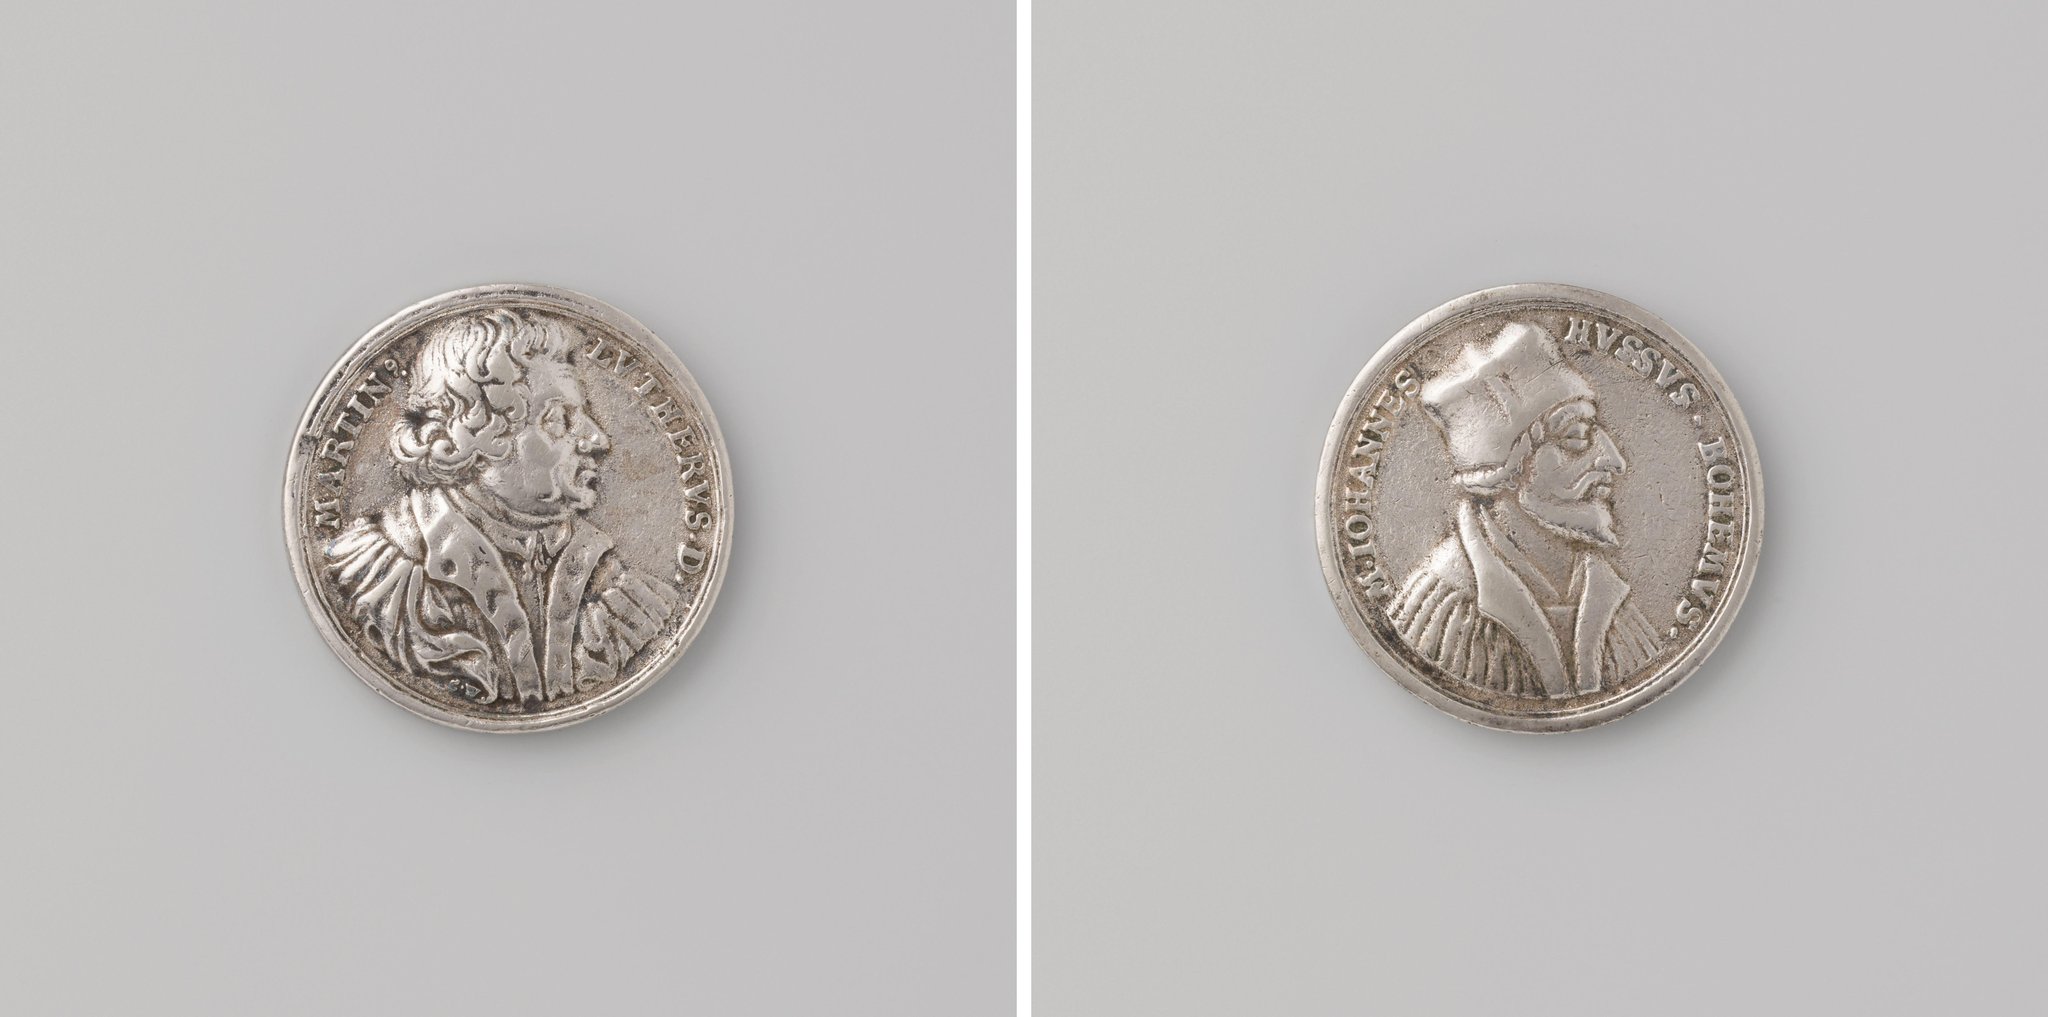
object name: history medal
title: Martin Luther en Johannes Hus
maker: christian wermuth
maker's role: medailleur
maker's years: 1661-1739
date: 1688-1739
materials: silver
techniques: striking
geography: nuremberg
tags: priest, martin luther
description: Zilveren penning. Voorzijde: borststuk man binnen omschrift. Keerzijde: borststuk man binnen omschrift